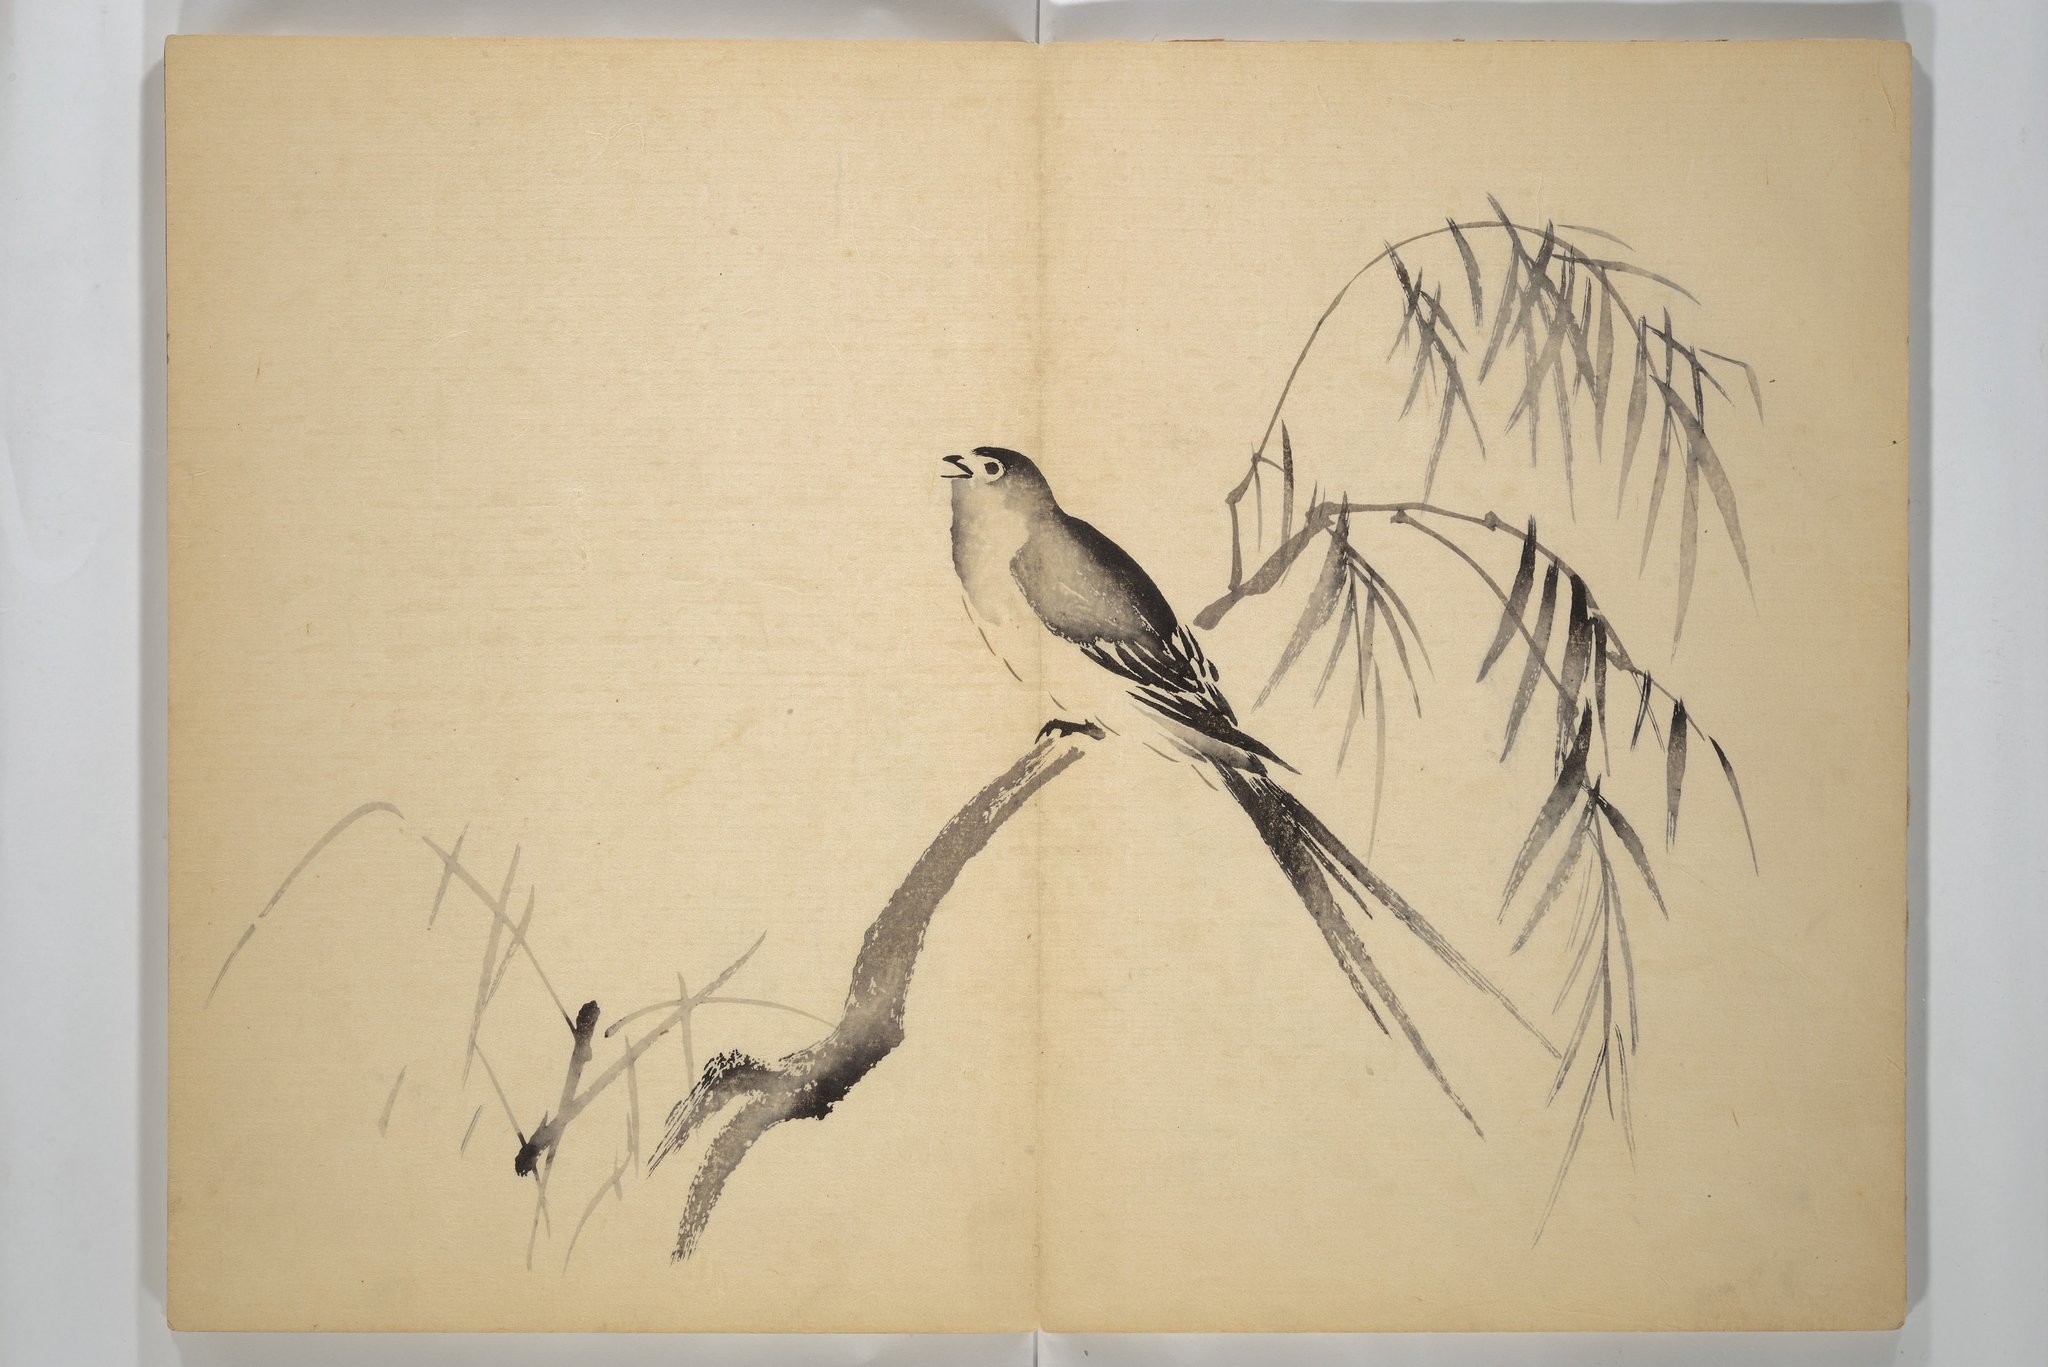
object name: illustrated book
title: Ōkyō Picture Album (Ōkyo gafu) 應舉画譜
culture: japanese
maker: maruyama ōkyo 円山応挙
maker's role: artist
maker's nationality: japanese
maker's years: 1733-1795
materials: ink, paper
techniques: woodblock print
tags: birds